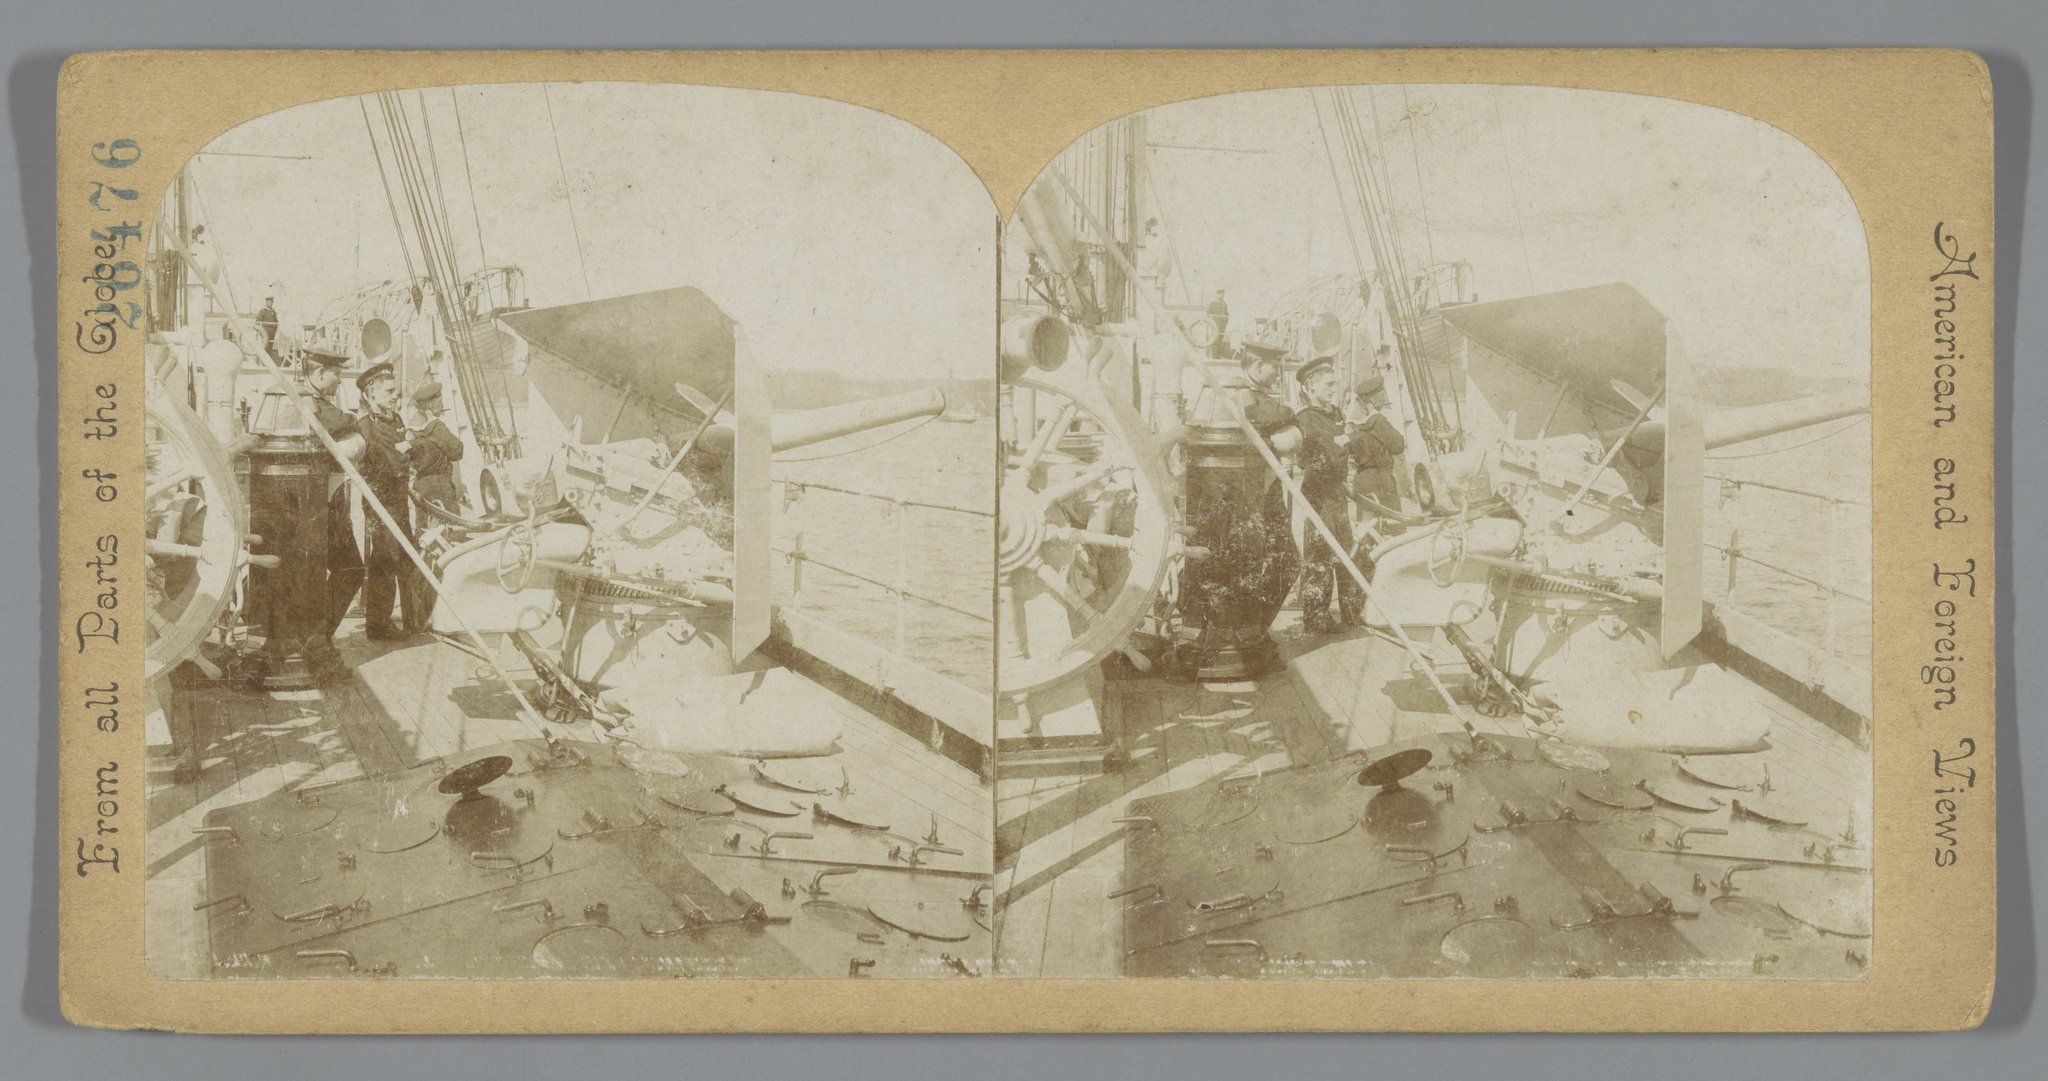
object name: stereograph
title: American and Foreign Views From all Parts of the Globe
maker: Anonymous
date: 1885-1920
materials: cardboard, paper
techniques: albumen print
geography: united states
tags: crew ~ ship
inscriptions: number: ‘26476’